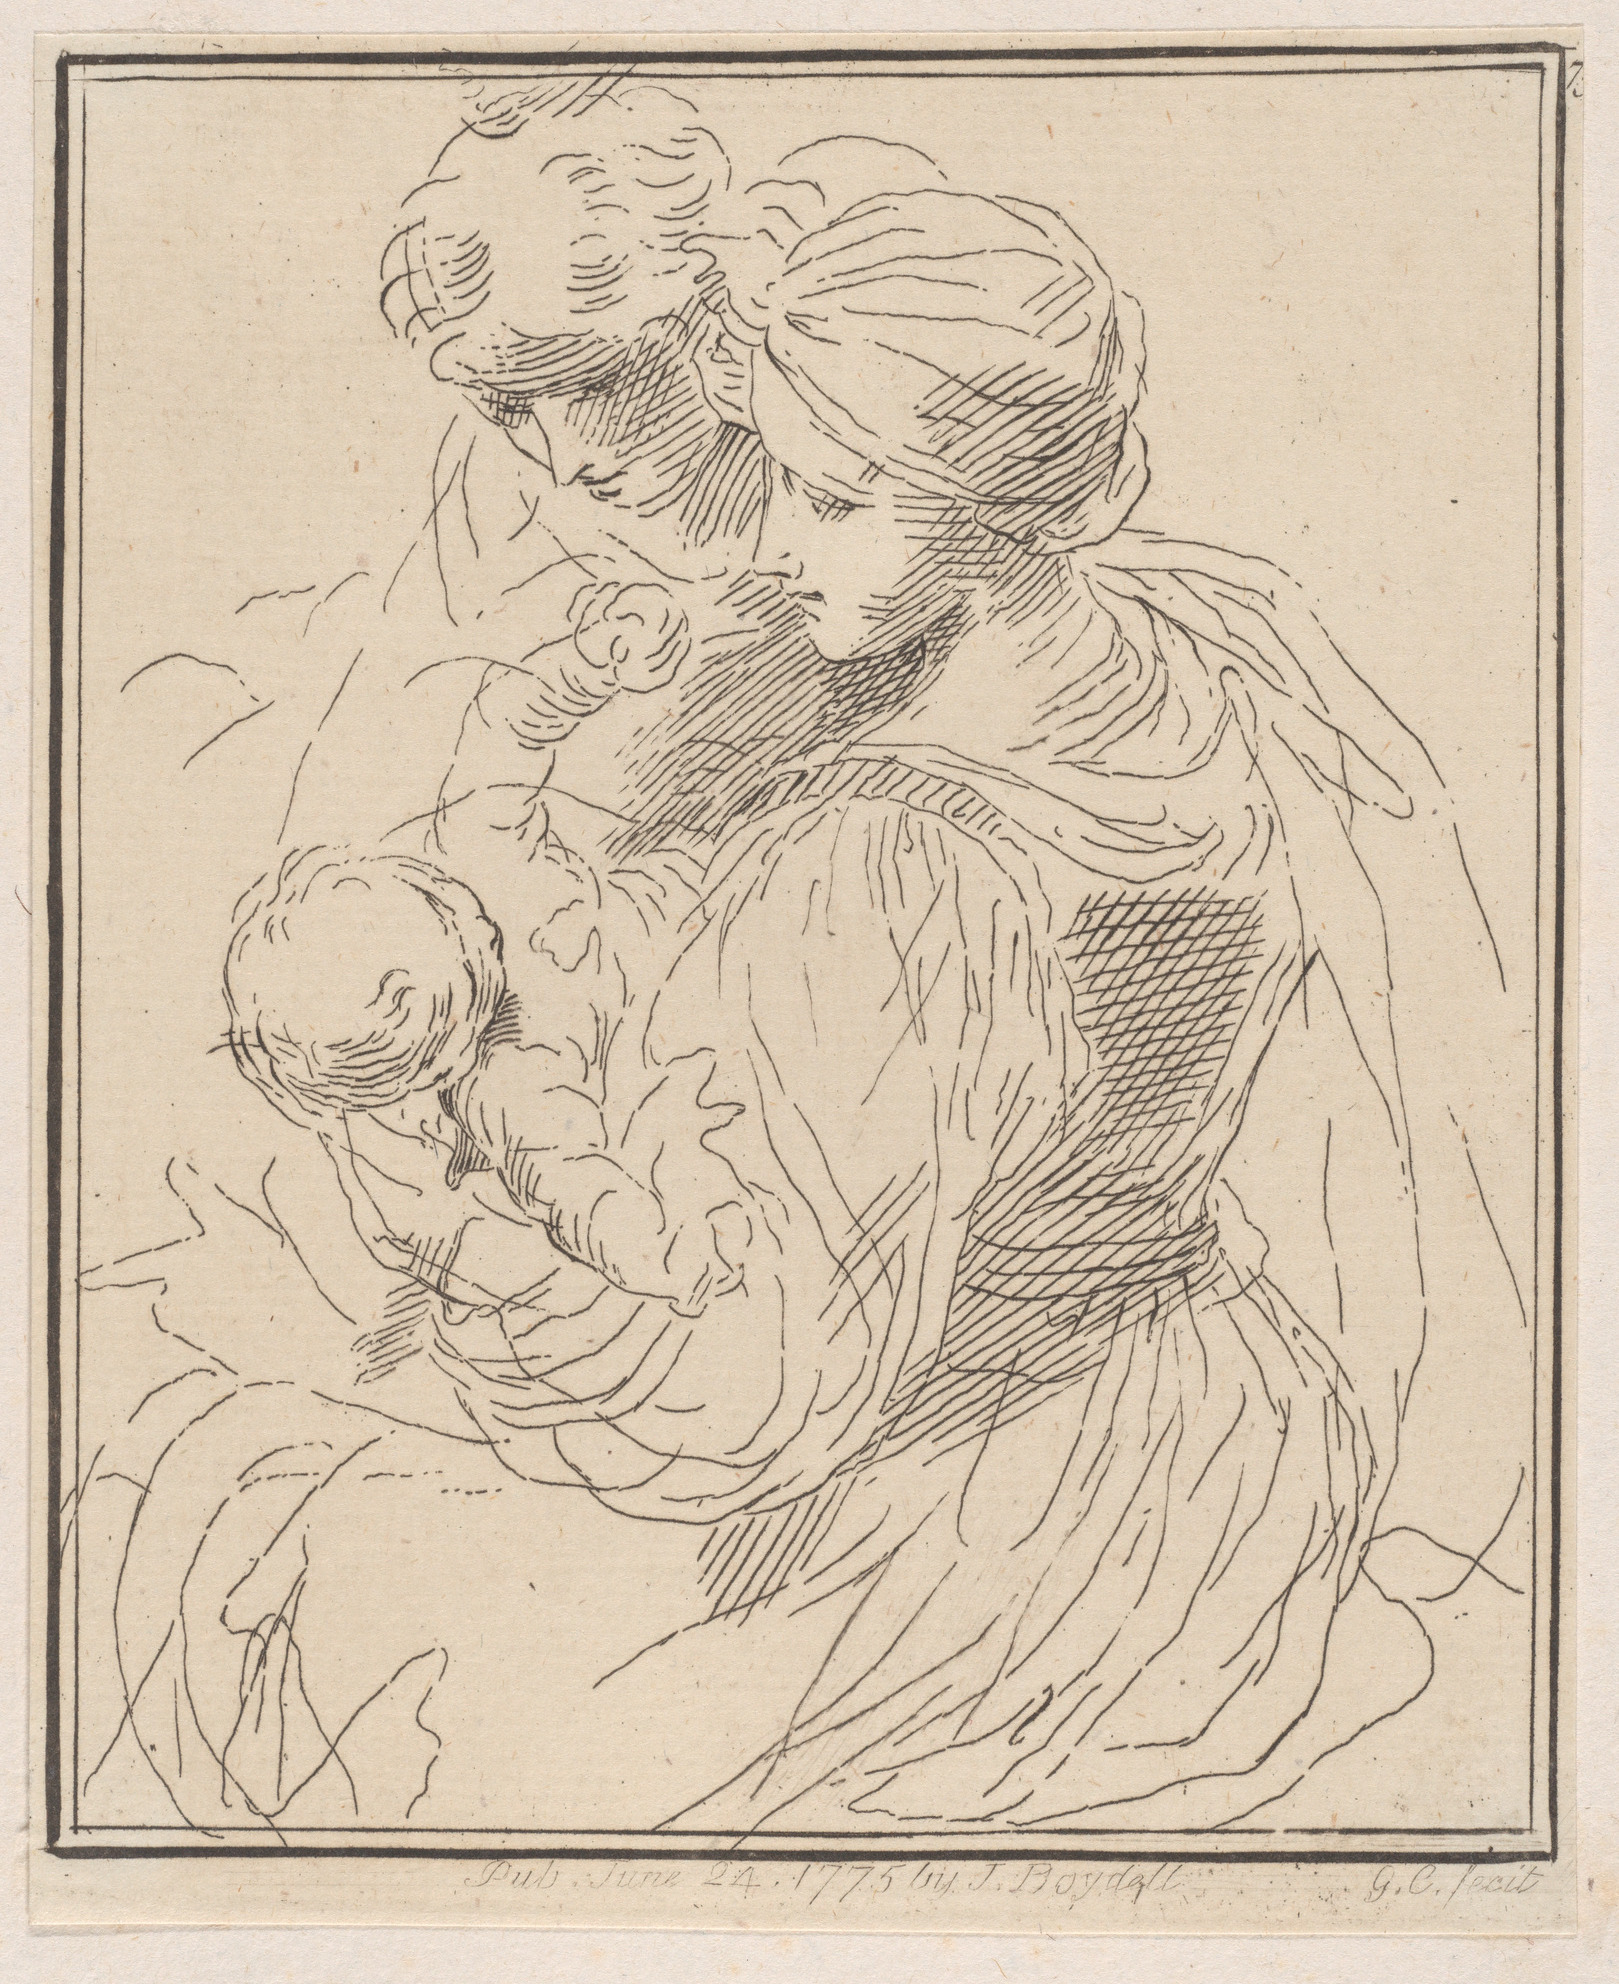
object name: print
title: Madonna and Child with Saint Anne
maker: giuseppe canale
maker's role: artist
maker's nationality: italian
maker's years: 1725-1802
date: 1775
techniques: etching